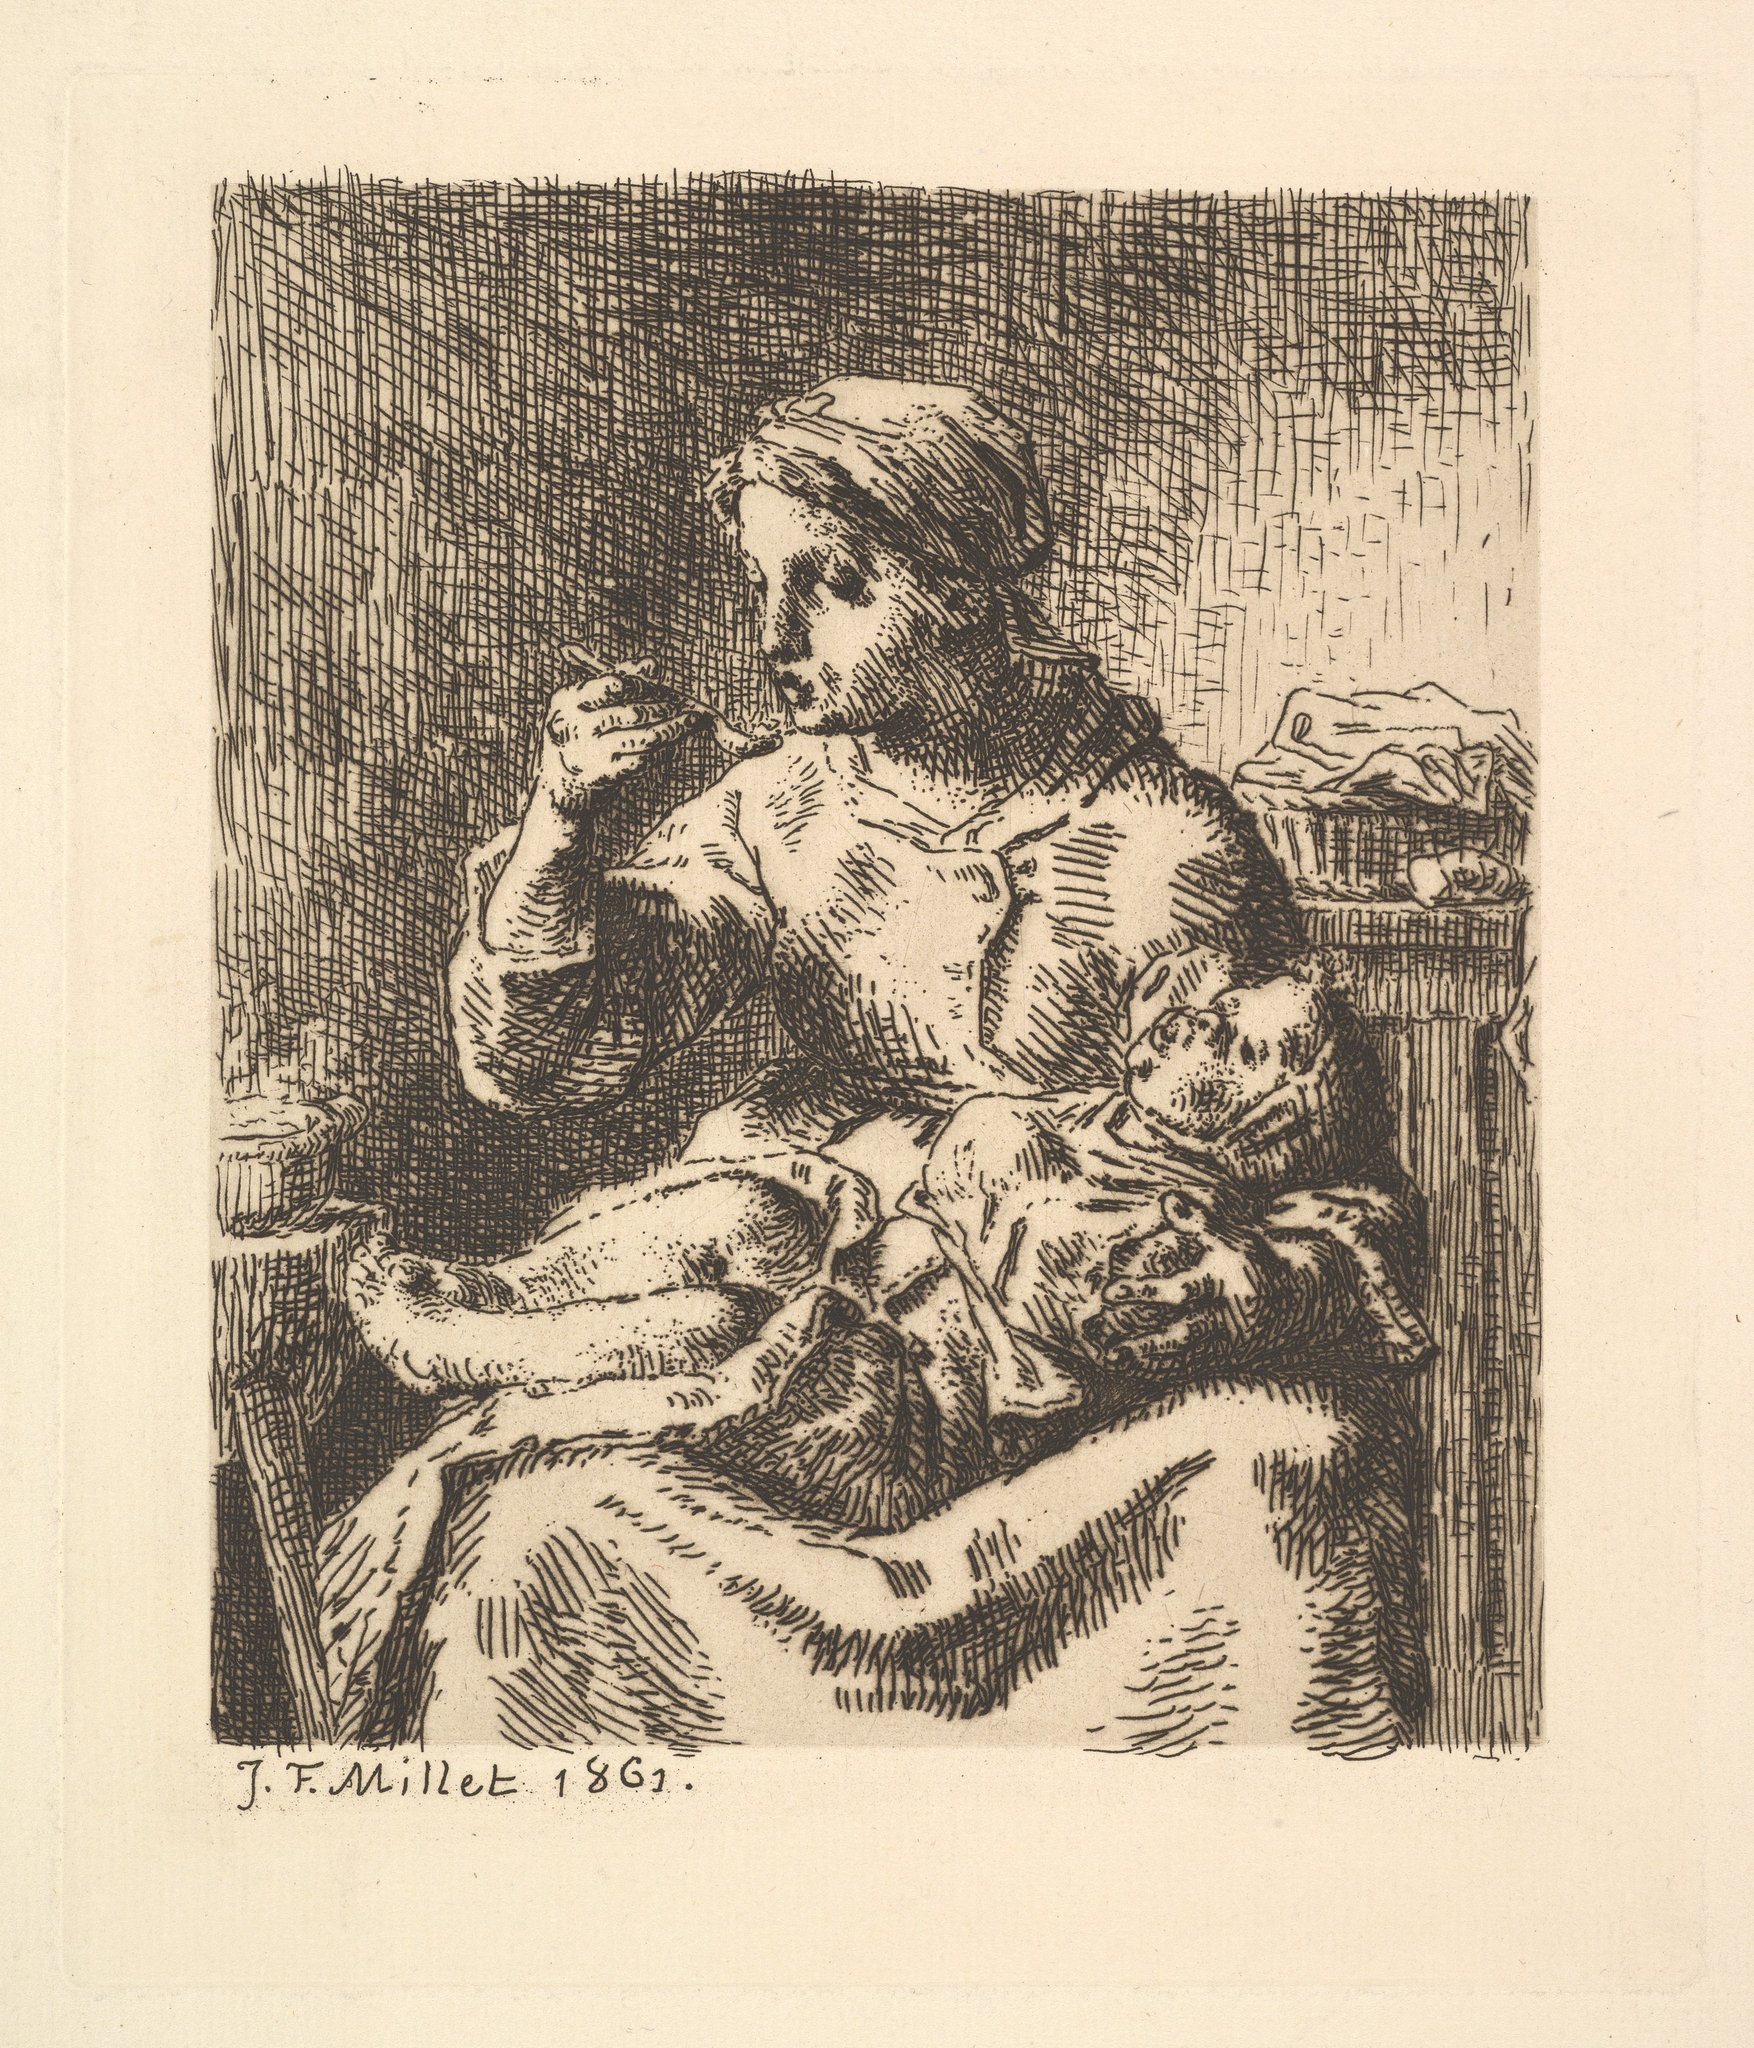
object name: print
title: Cooling the Porridge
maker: jean-françois millet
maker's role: artist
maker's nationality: french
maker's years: 1814-1875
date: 1861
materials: paper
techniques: etching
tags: infants,women